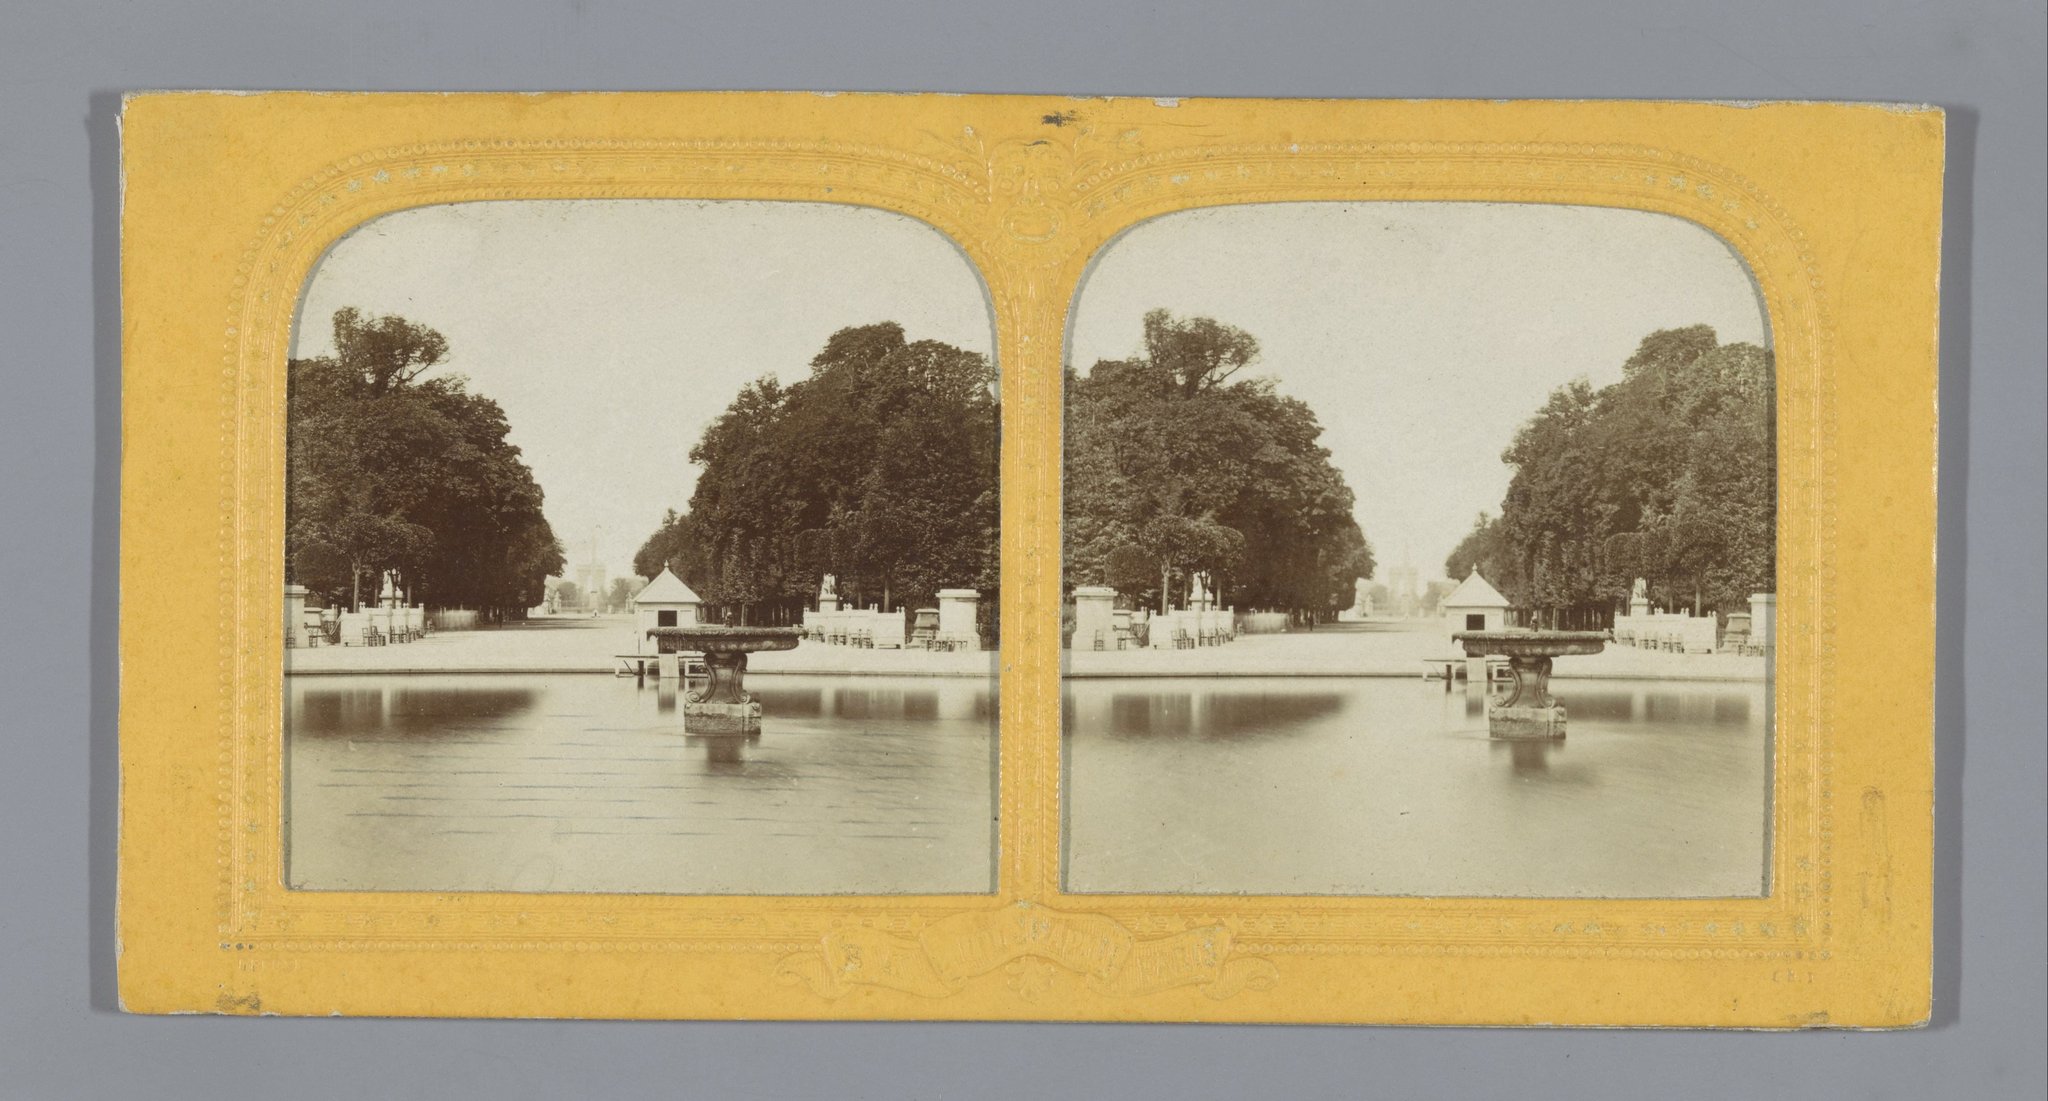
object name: tissue stereograph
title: Les Tuileries, Paris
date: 1863-1875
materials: cardboard, paper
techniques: albumen print, cutting, hand coloring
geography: paris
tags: park, garden pond, public gardens, park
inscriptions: inscription: ‘Déposé’